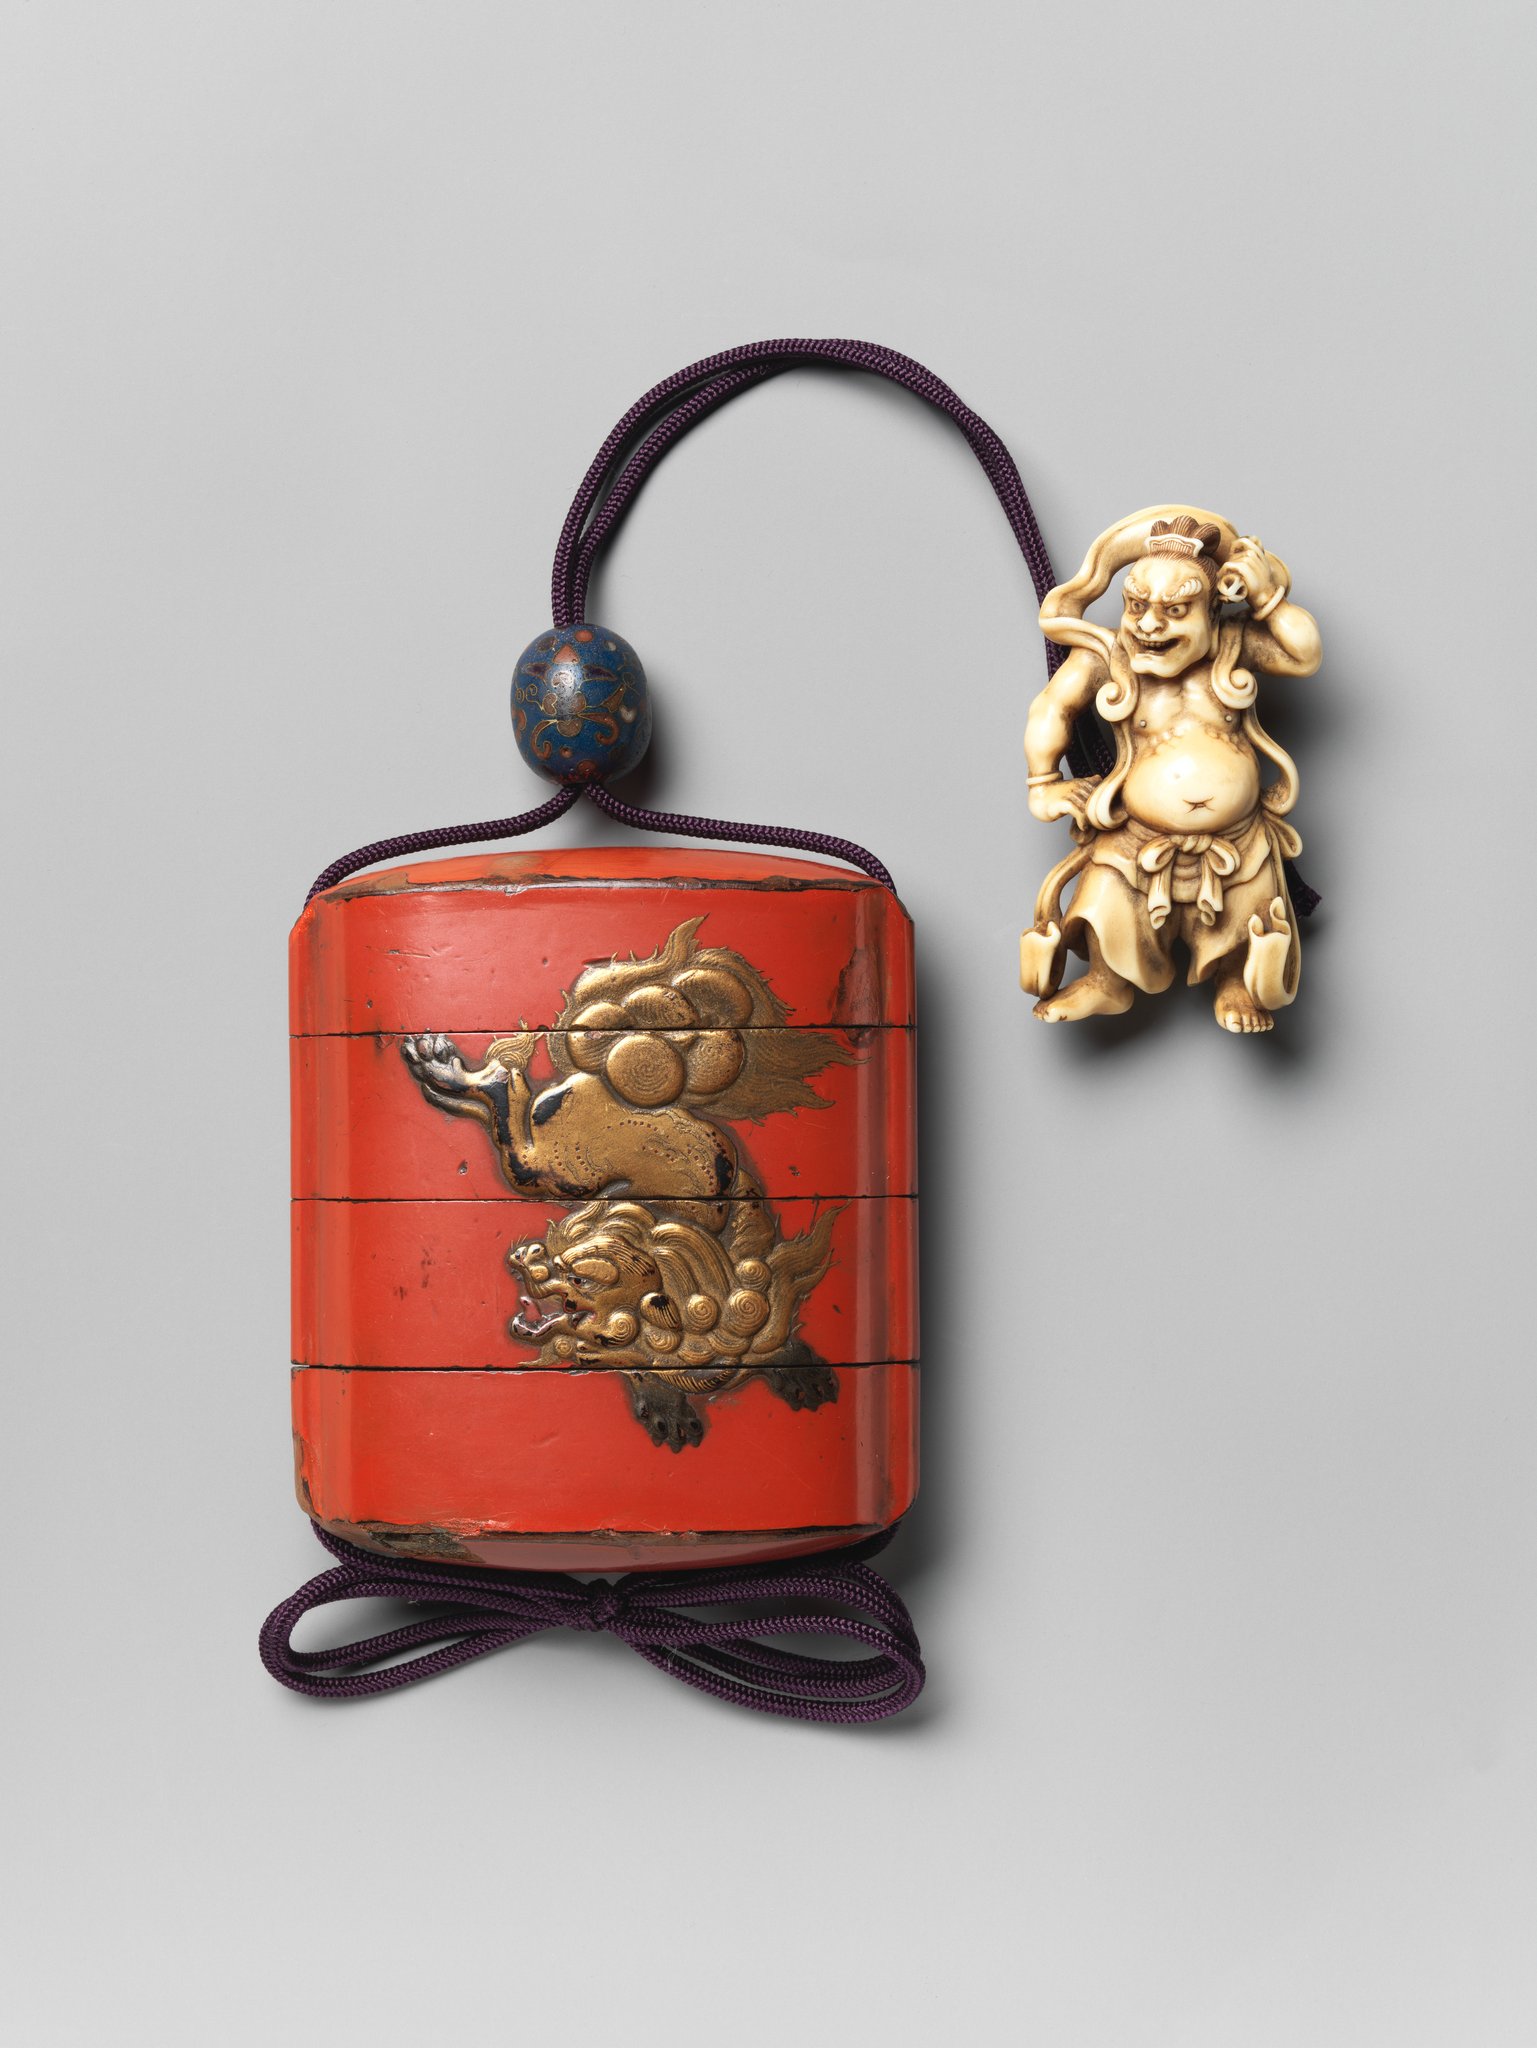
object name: inrō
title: Case (Inrō) with Lion and Peonies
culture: japanese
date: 1601-1700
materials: lacquer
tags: men,lions,peonies